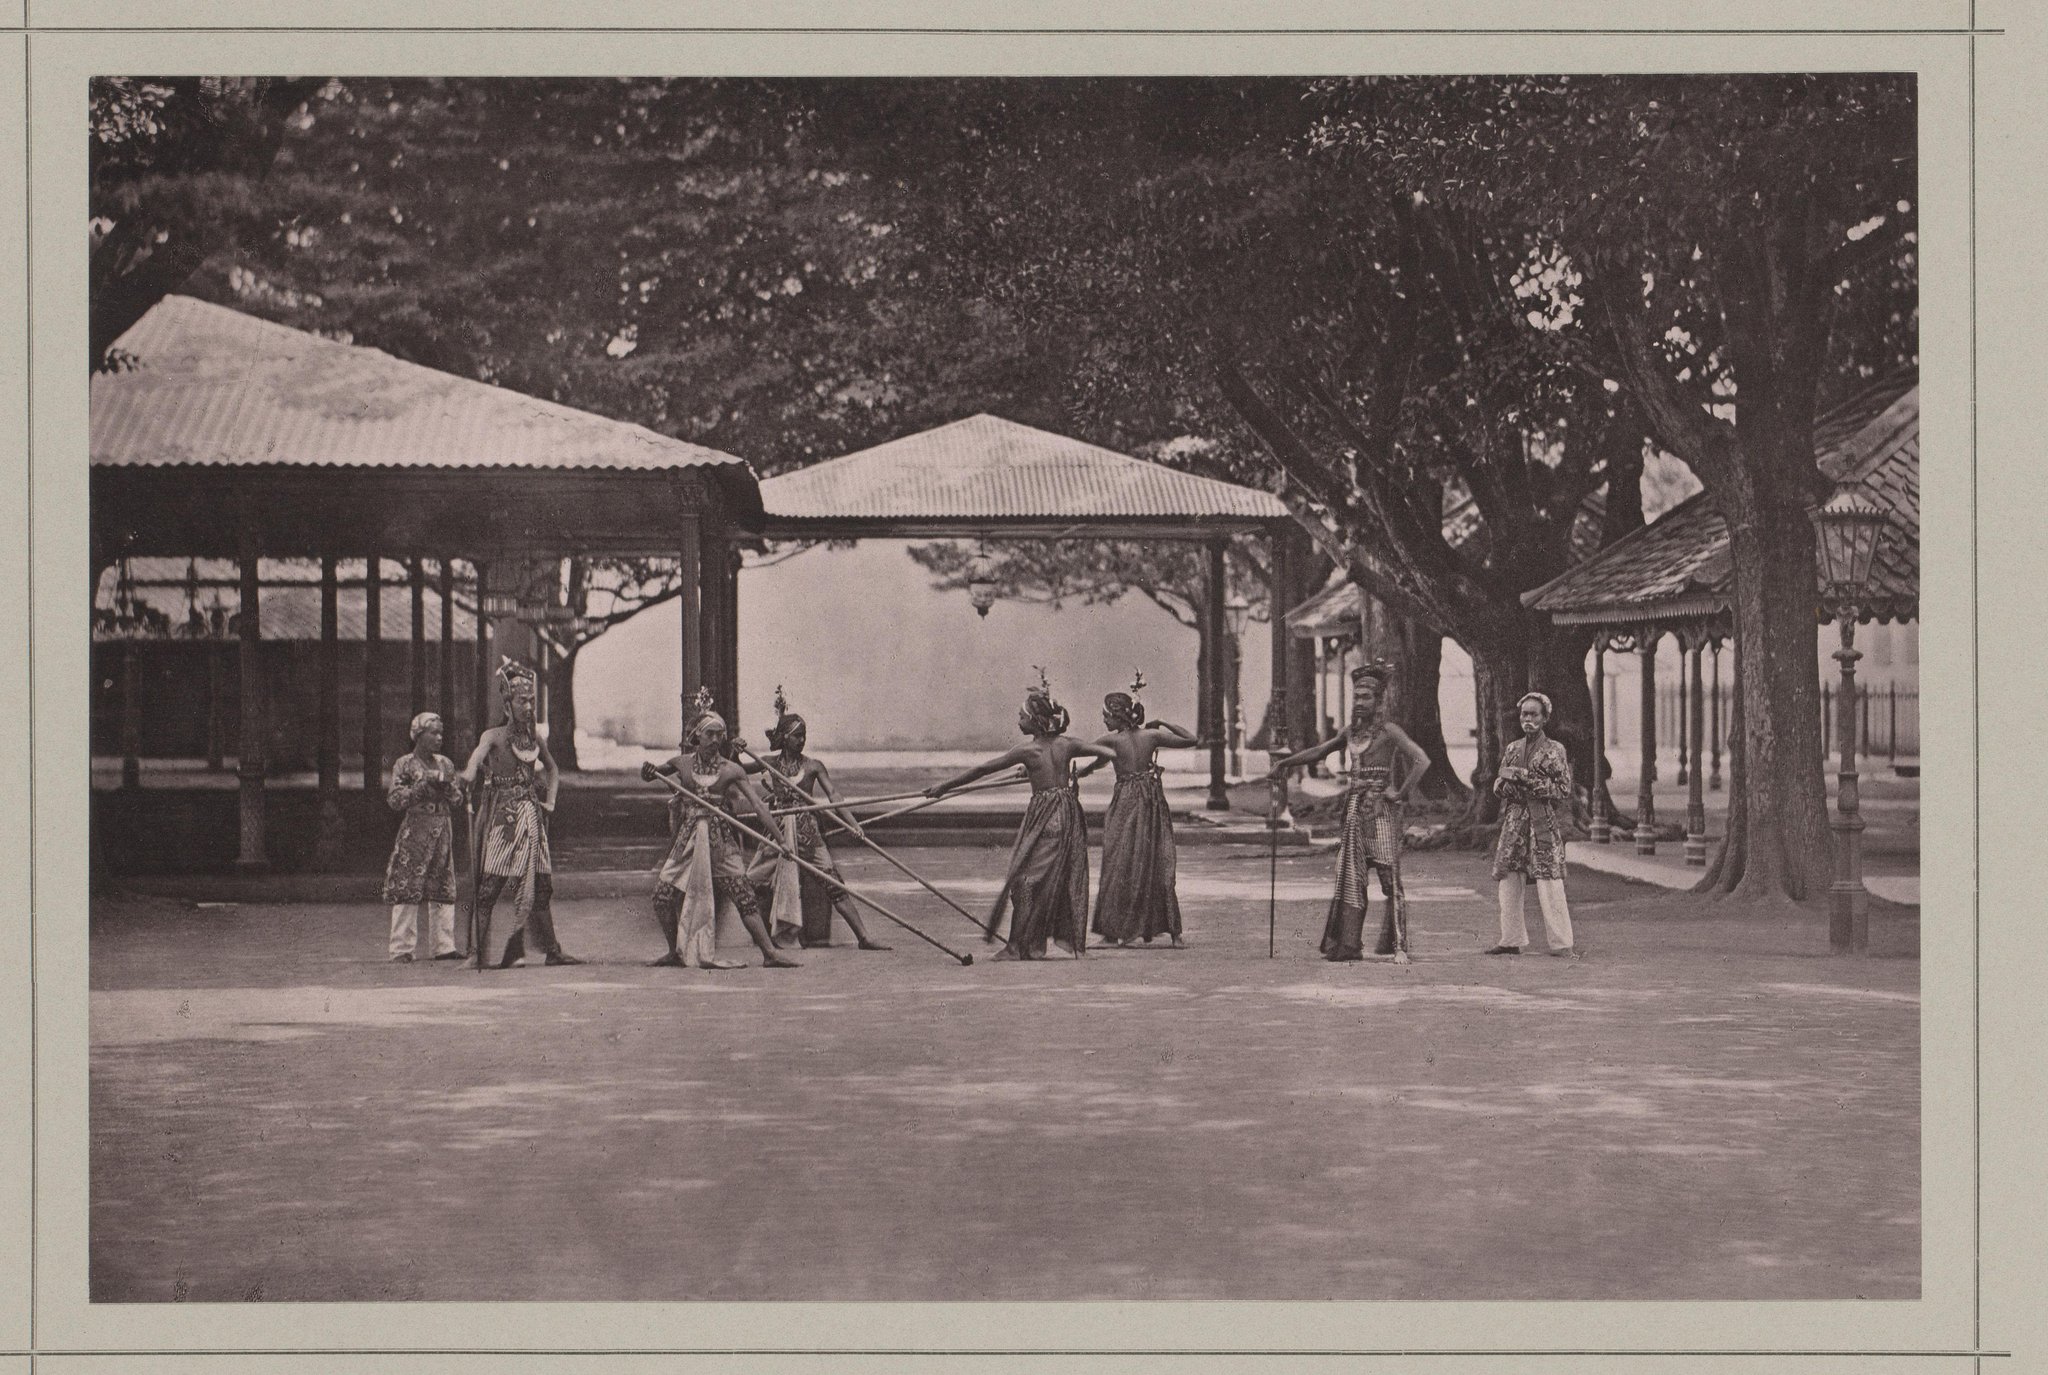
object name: photomechanical print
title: Toneelvoorstelling van een gevecht, in de Kraton Ngayogyakarta Hadiningrat in Jogyakarta, Indonesië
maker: kassian céphas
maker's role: fotograaf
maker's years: 1845-1912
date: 1883-1888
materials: paper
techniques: photograph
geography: yogyakarta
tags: group of actors, troupe; actors on the stage, fighting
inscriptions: number: ‘XV’